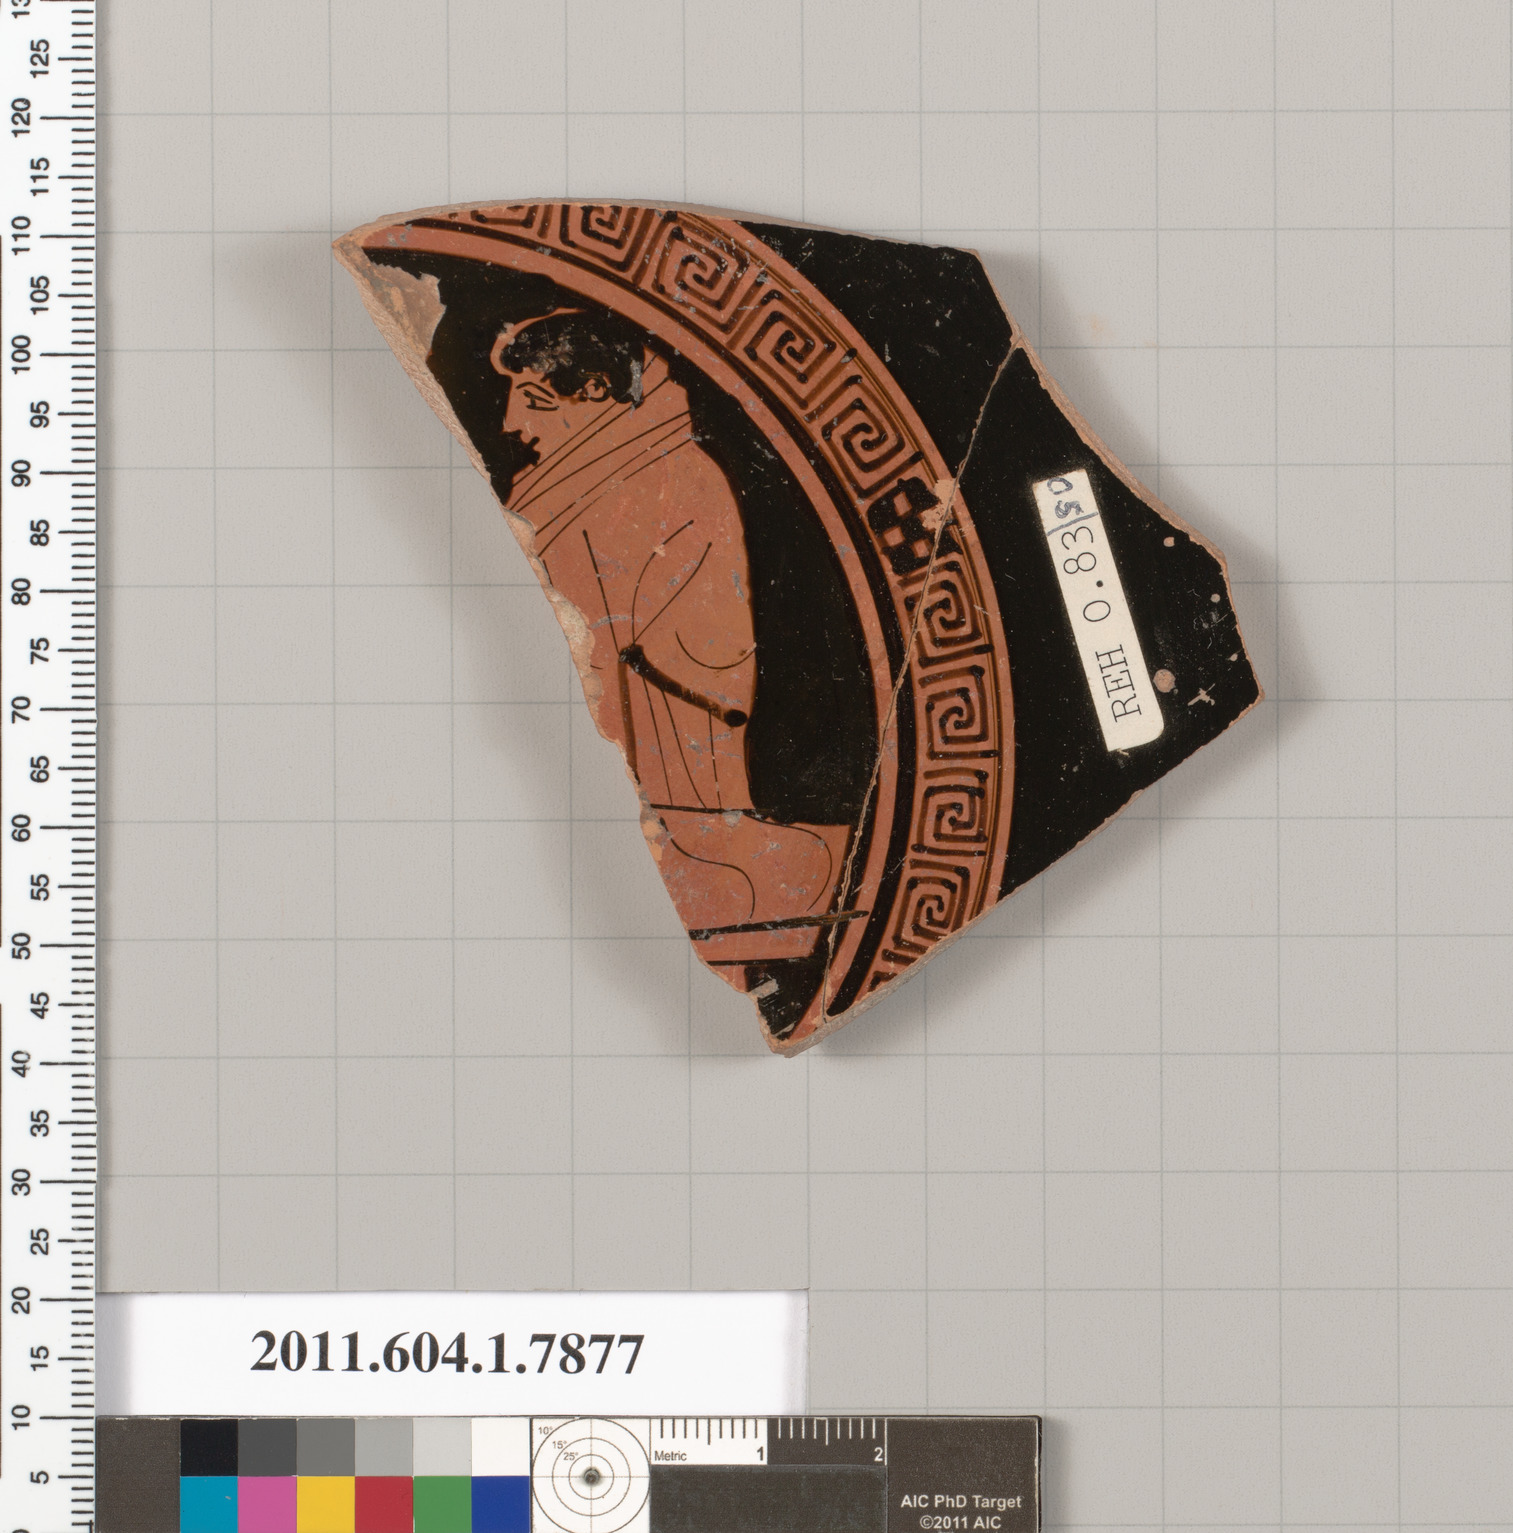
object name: kylix fragment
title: Terracotta fragment of a kylix (drinking cup)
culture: greek, attic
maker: veii painter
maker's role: artist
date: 460-450 BCE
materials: terracotta